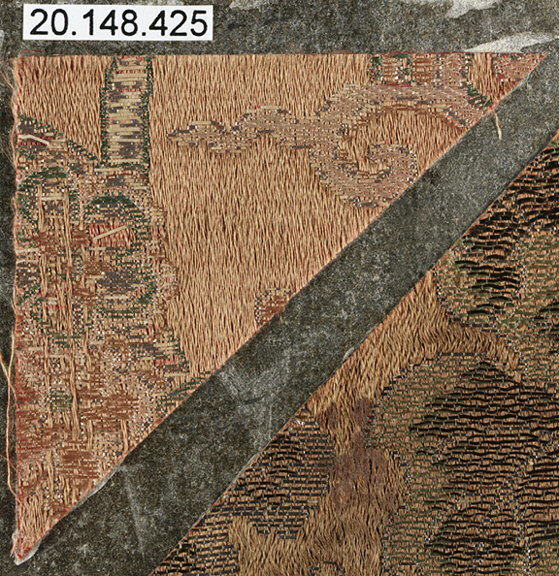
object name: piece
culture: japanese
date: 1601-1700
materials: silk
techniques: compound weave